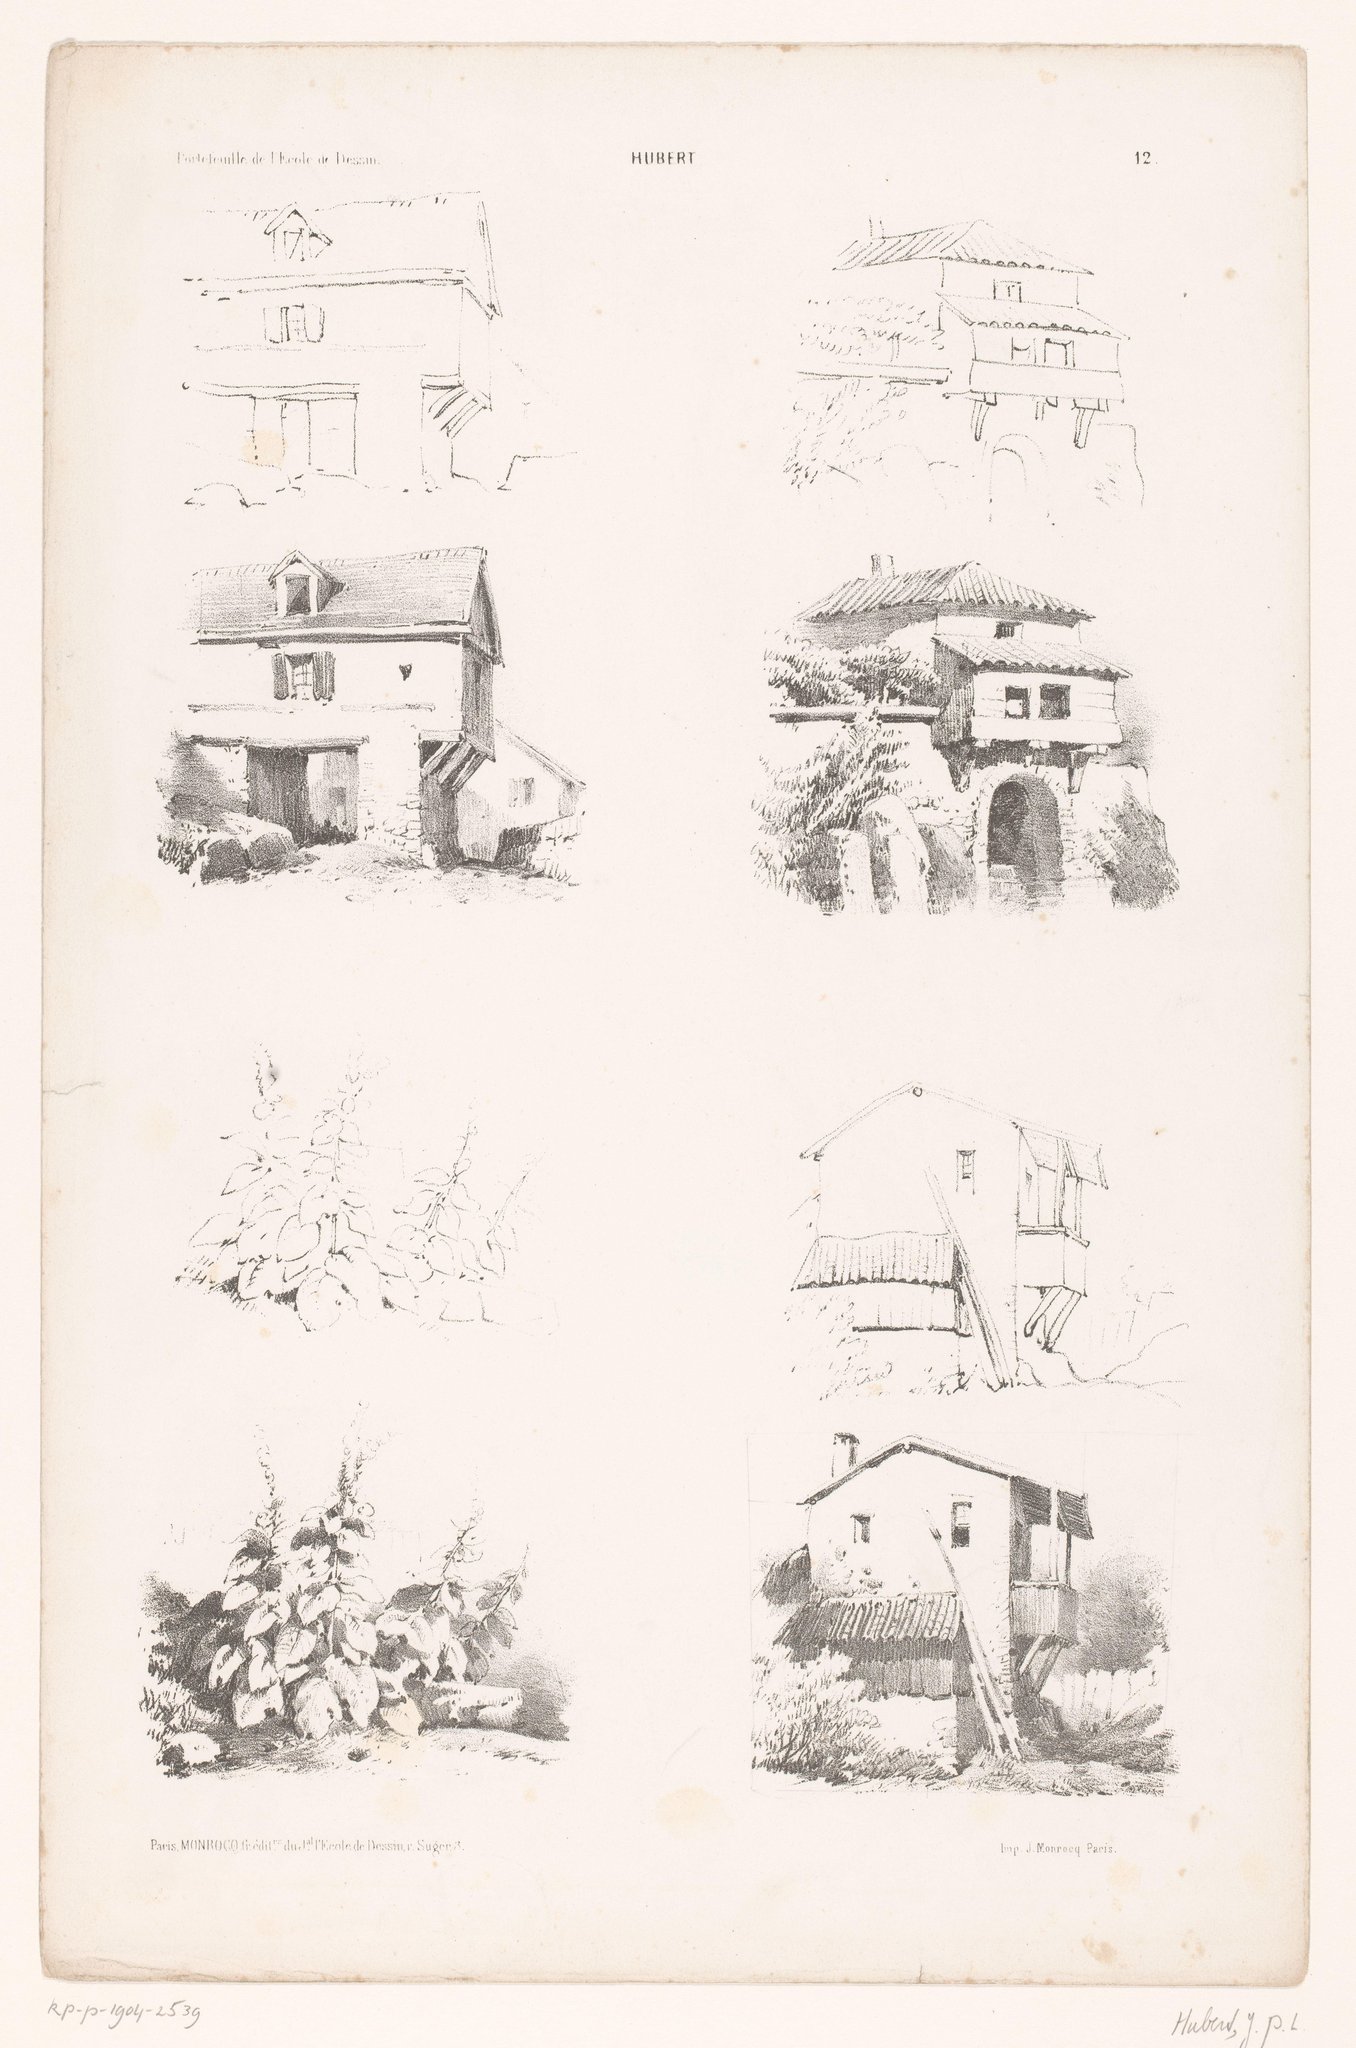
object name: print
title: Portefeuille de l'École de Dessin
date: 1853-1854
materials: paper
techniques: lithograph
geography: paris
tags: rural housing, e.g. country-house, villa, cottage, plants and herbs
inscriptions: collector's mark: Lugt 2228a